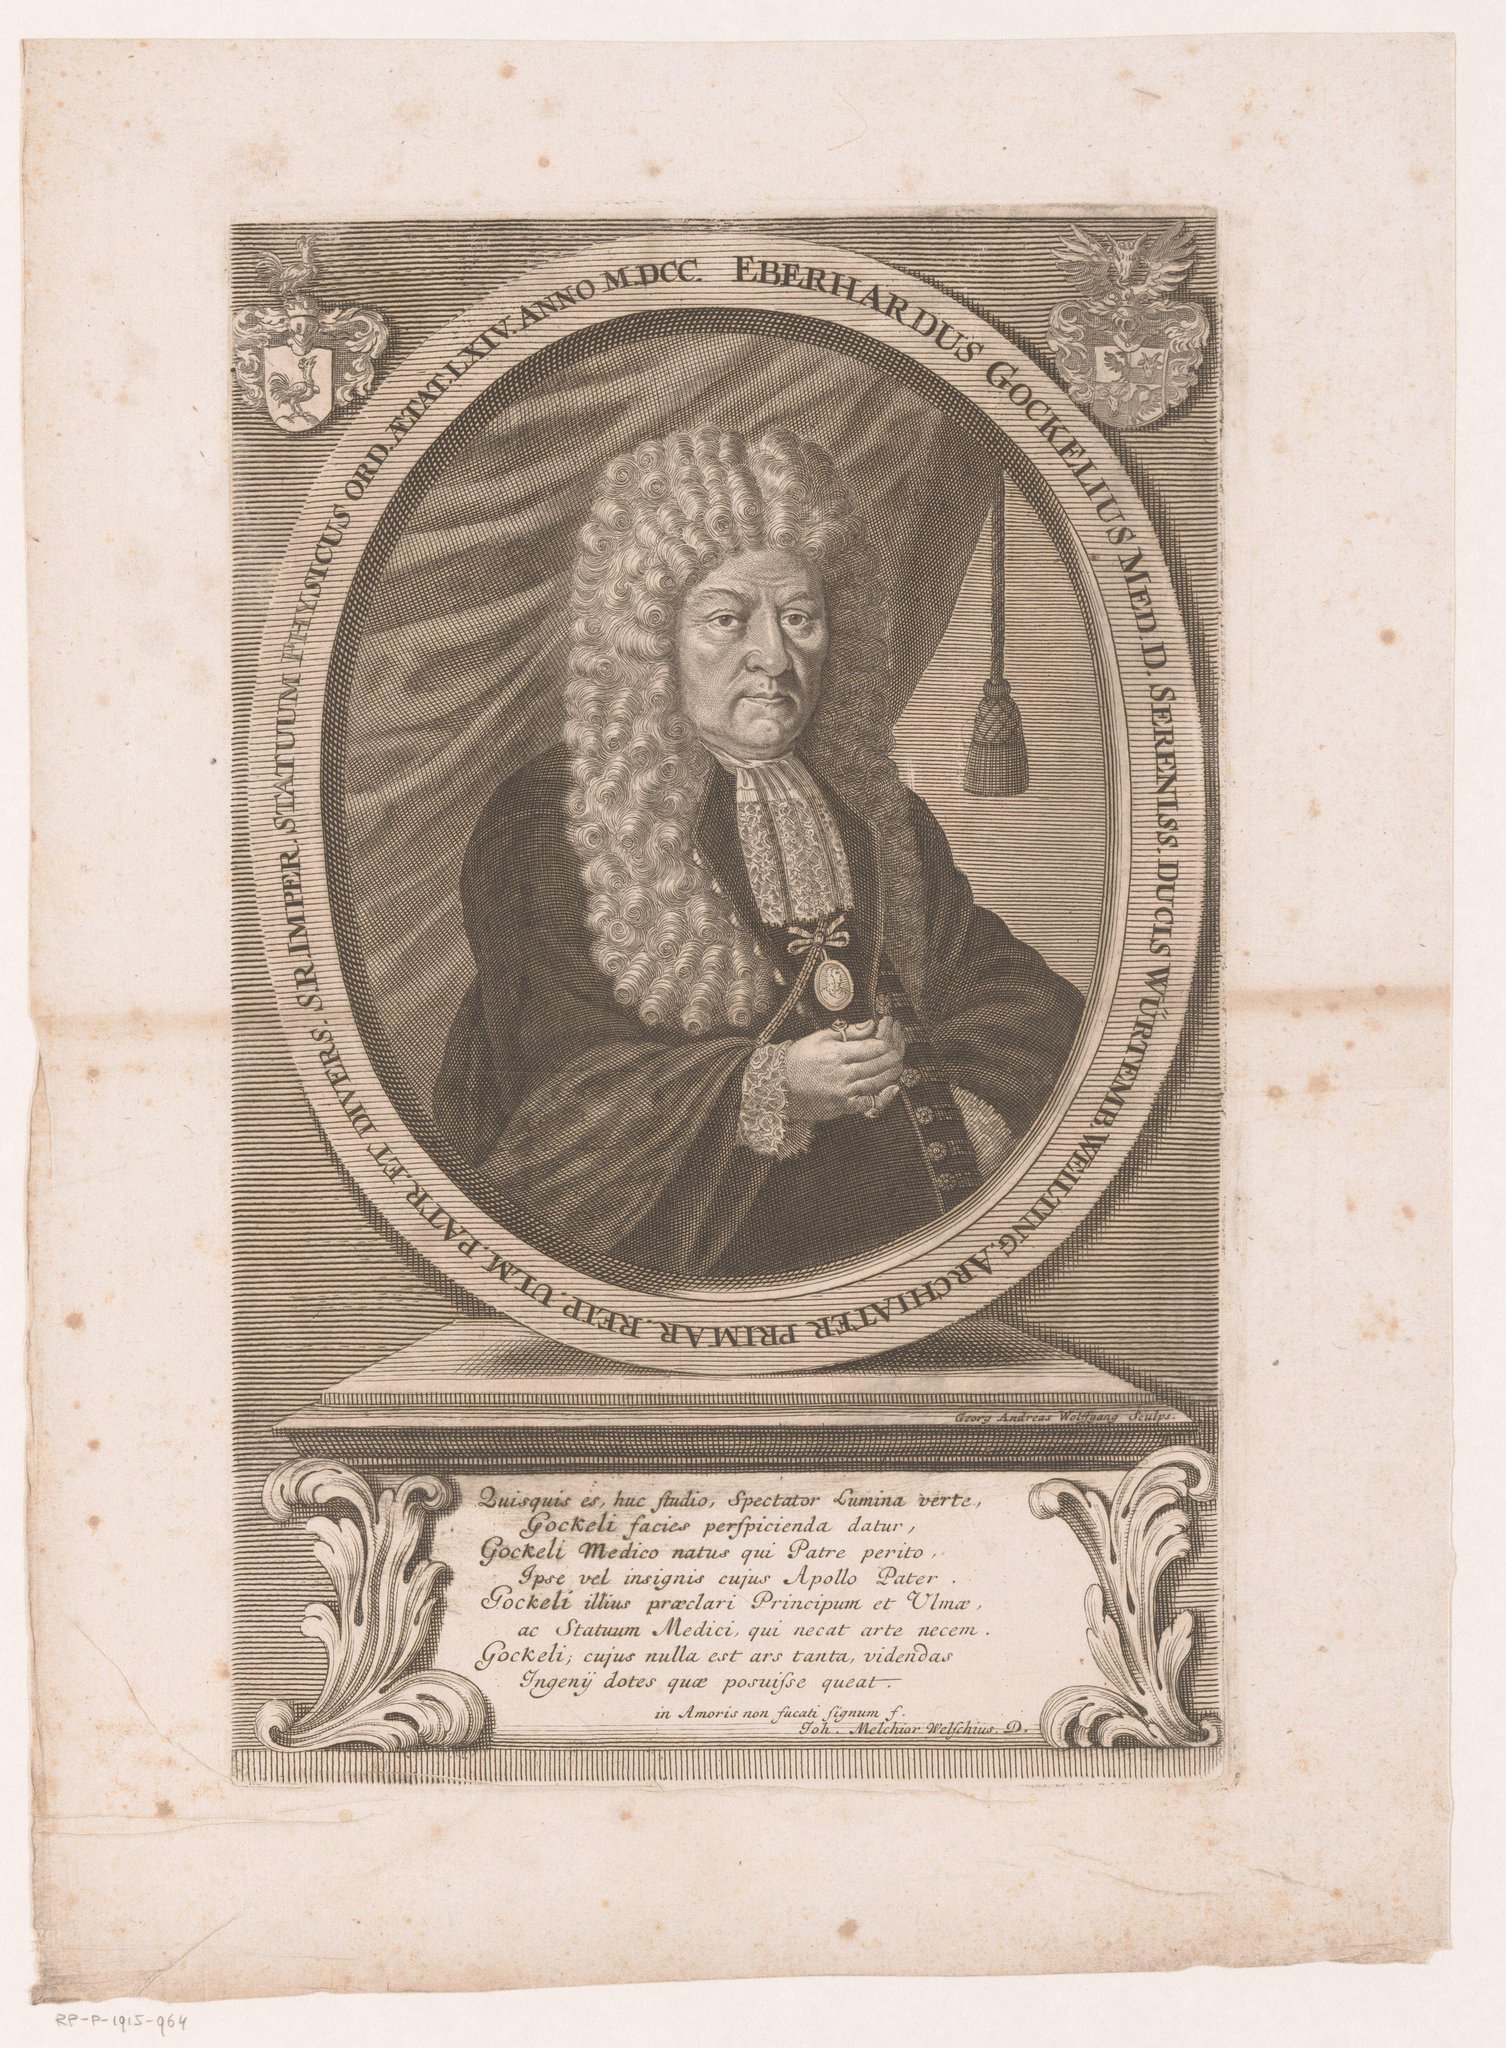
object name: print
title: Portret van Eberhard Gockel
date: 1670-1716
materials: paper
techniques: engraving, etching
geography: germany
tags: historical persons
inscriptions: collector's mark: Lugt 2228